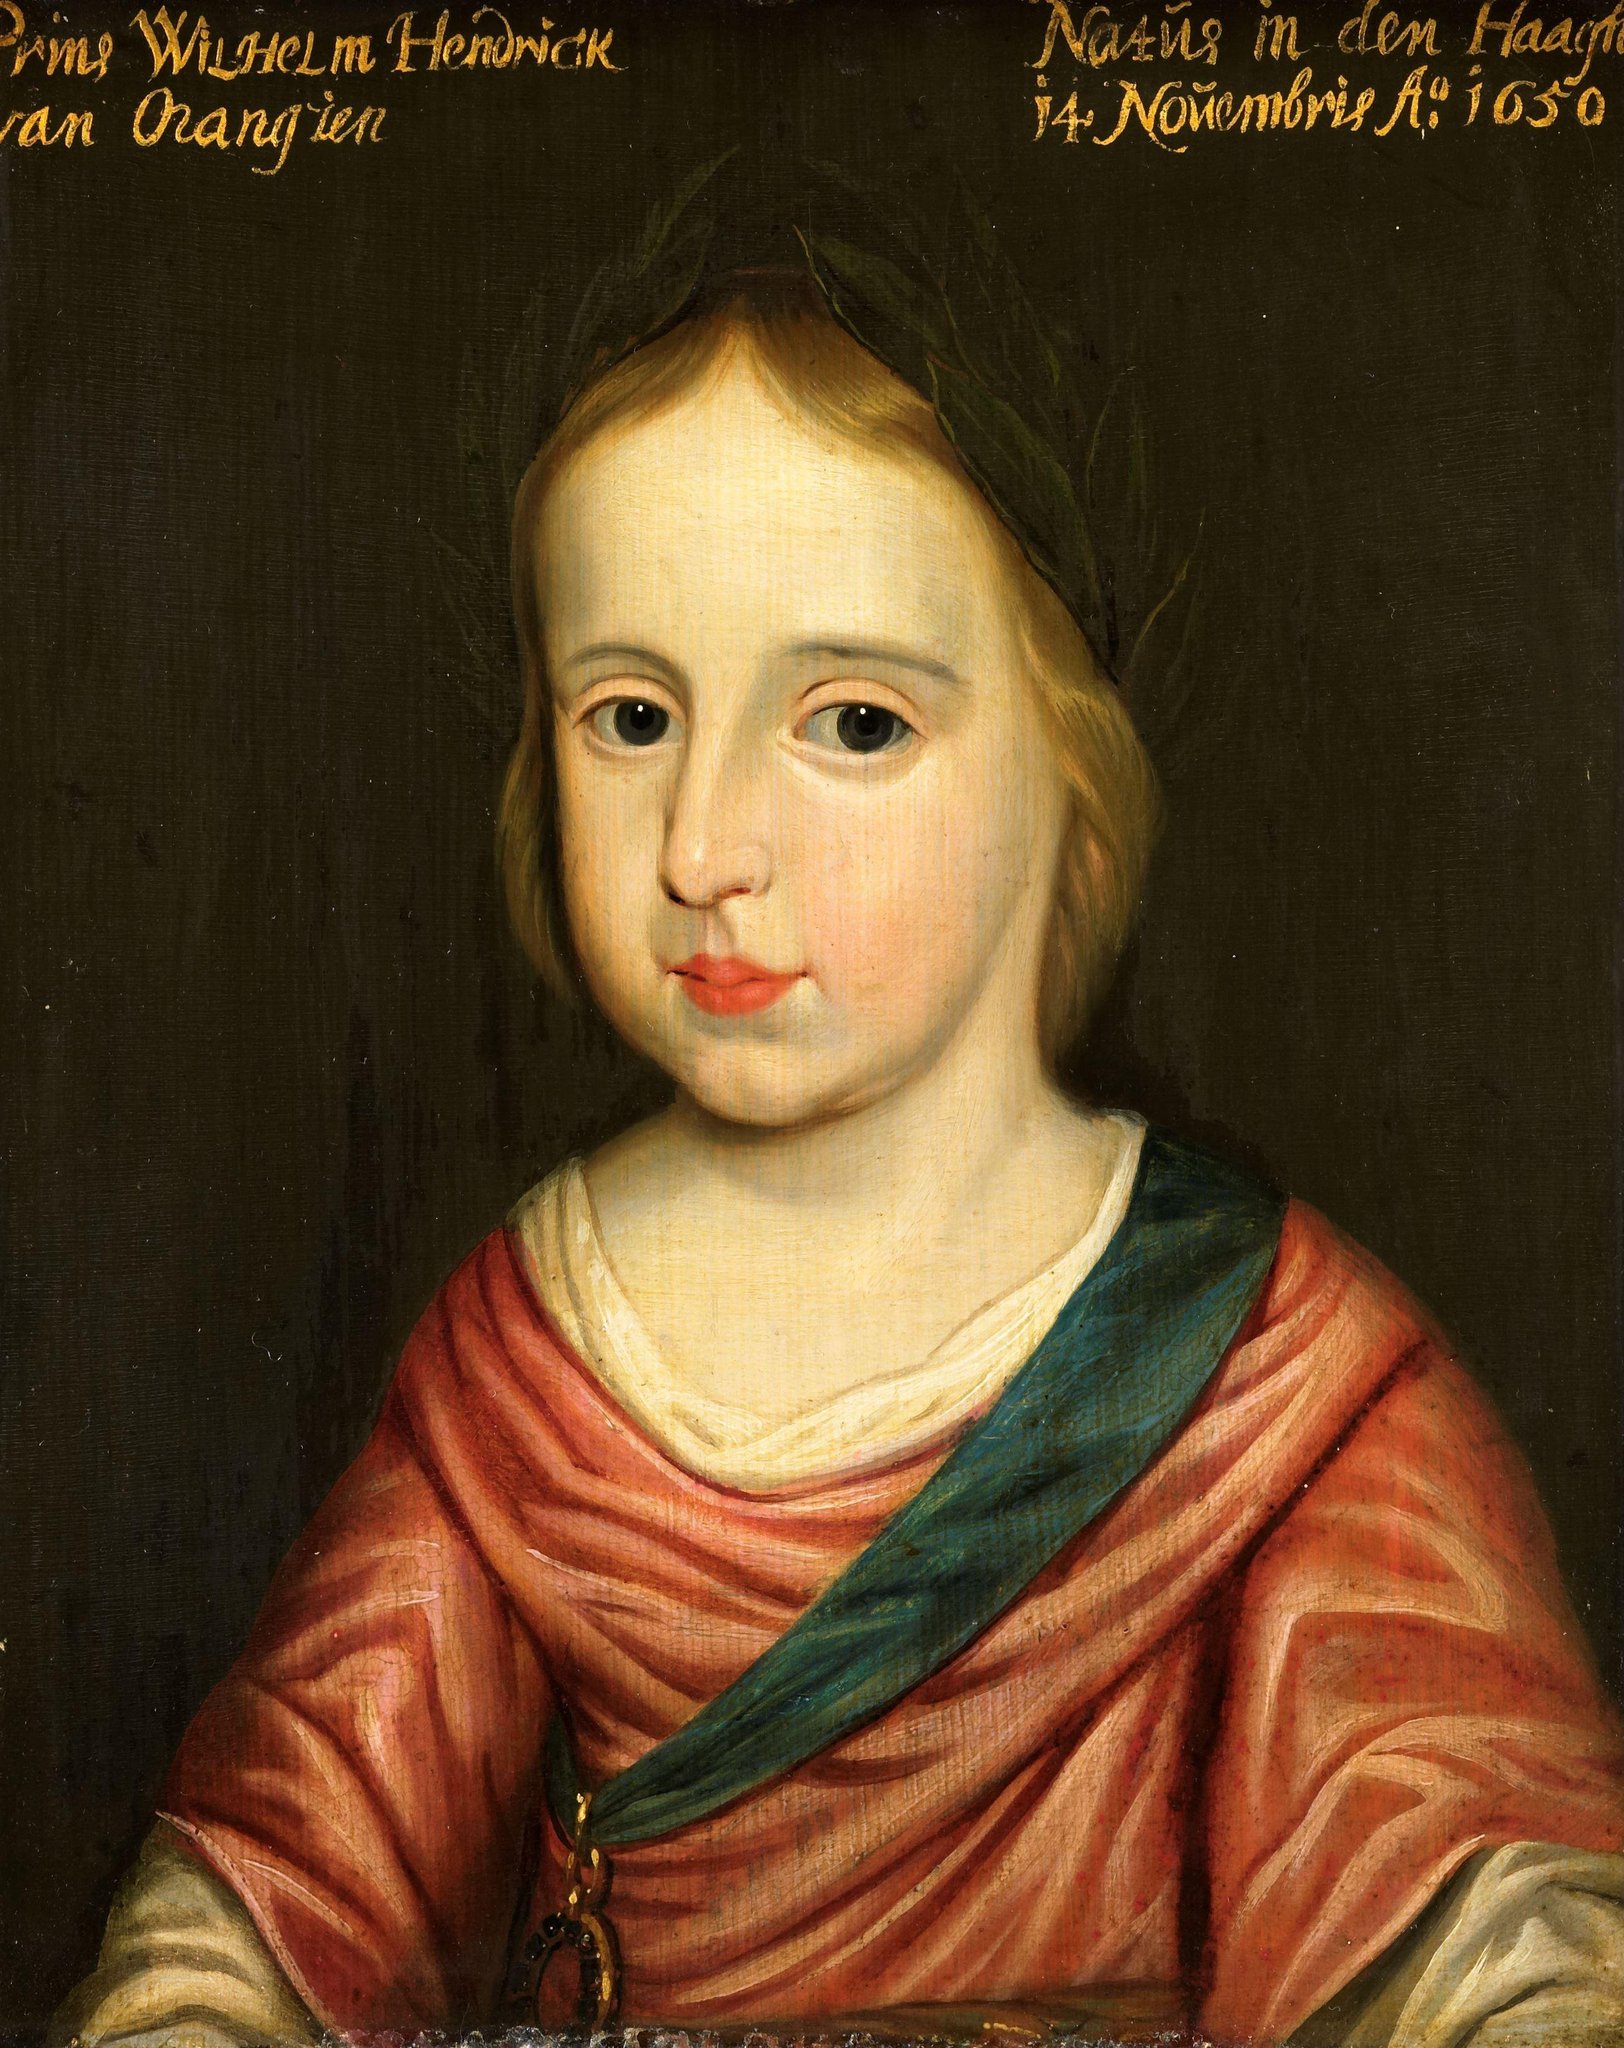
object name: painting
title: Portrait of Willem III (1650-1702), Prince of Orange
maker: gerard van honthorst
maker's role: draughtsman, painter, print maker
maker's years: 1592-1656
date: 1653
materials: oil, panel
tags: the hague, william iii (prince of orange and king of england, scotland, and ireland), historical persons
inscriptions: inscription, top: ‘Prins Wilhelm Hendrick von Orangien / Natus in den Haagh 14 Novembris Aº 1650’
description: Portret van Willem III (1650-1702), prins van Oranje, als kind. Buste naar links. Kopie naar een schilderij van Gerard van Honthorst. Onderdeel van de reeks portretten afkomstig uit het Stadhouderlijk Hof te Leeuwarden.